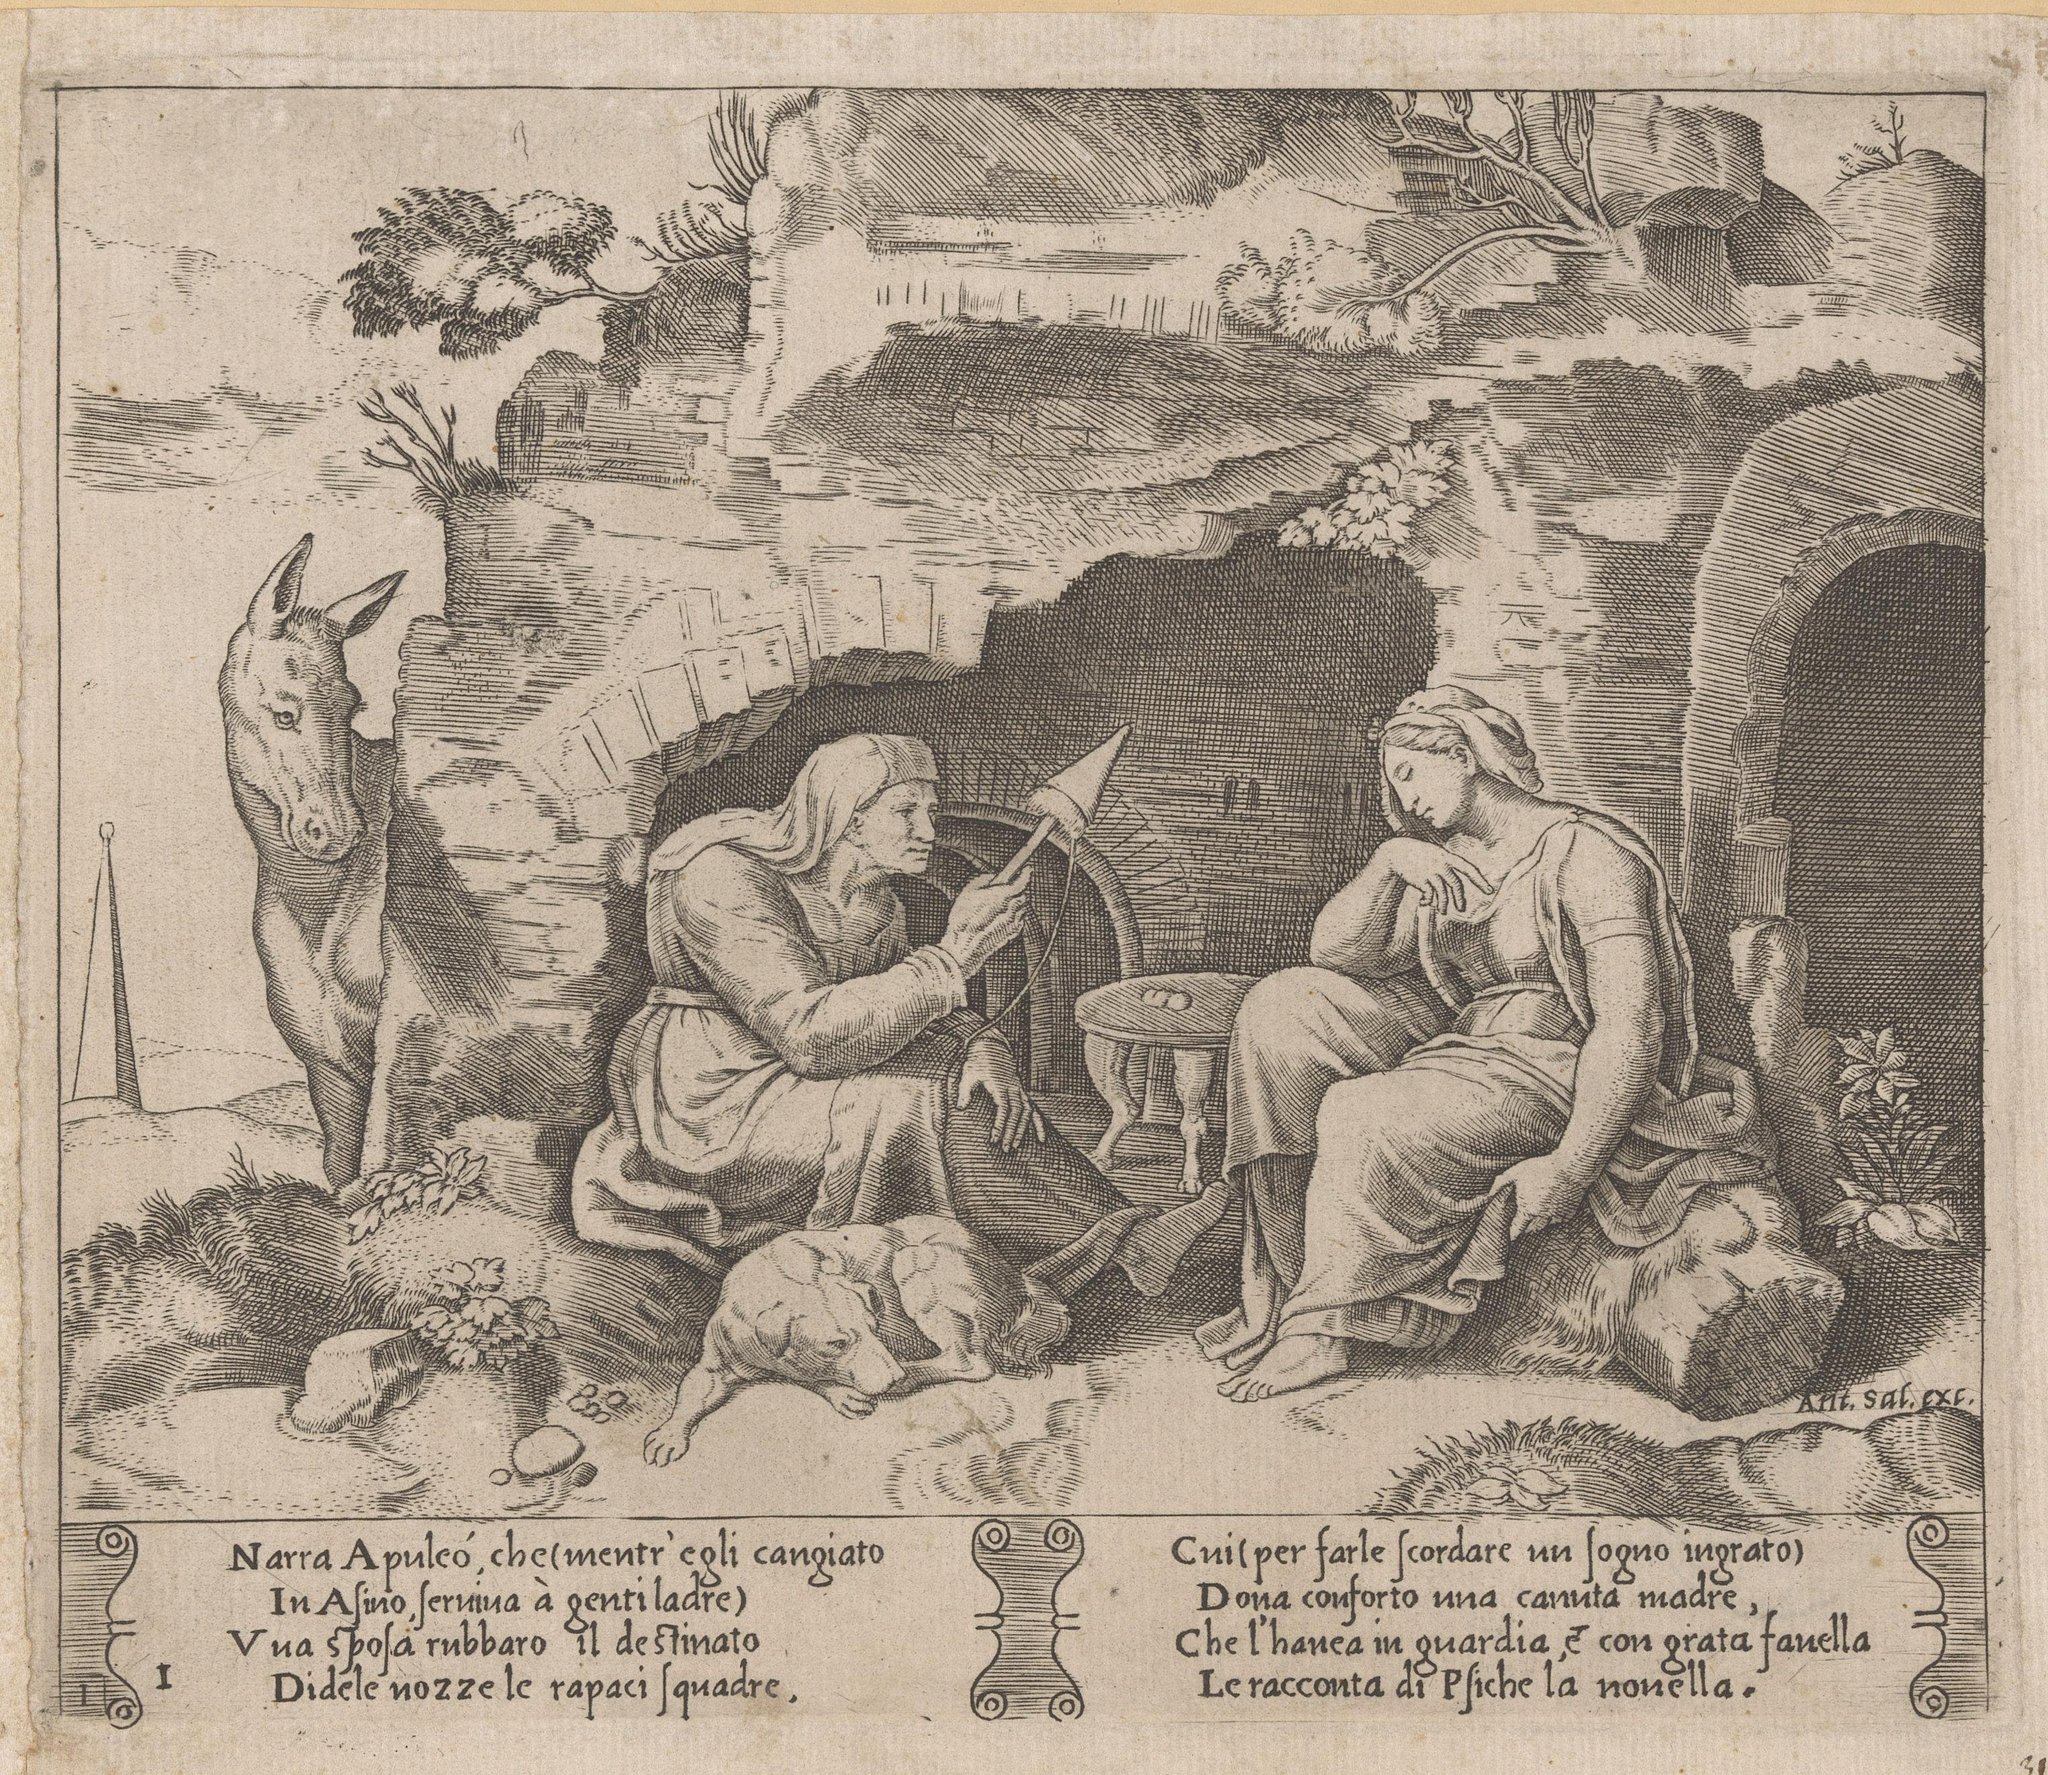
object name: print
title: Verhaal van Amor en Psyche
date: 1530-1560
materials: paper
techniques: engraving, etching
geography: italy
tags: ass, donkey, distaff, story of cupid and psyche (apuleius, 'metamorphoses' (golden ass) iv 28 - vi 25)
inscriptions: collector's mark: Lugt 10, collector's mark: ‘Hinloopen’, number: ‘31’, collector's mark: Lugt 11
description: Lucius, de hoofdpersoon uit Apuleius' roman 'Metamorphosen', is veranderd in een ezel en hoort een oude vrouw het verhaal van Amor en Psyche vertellen aan een jonge vrouw. Voor de opening van een grot zitten links de oude vrouw met spinrok en hond en rechts de jonge vrouw. Italiaanse tekst in twee cartouches in ondermarge. Tweemaal genummerd linksonder: 1.